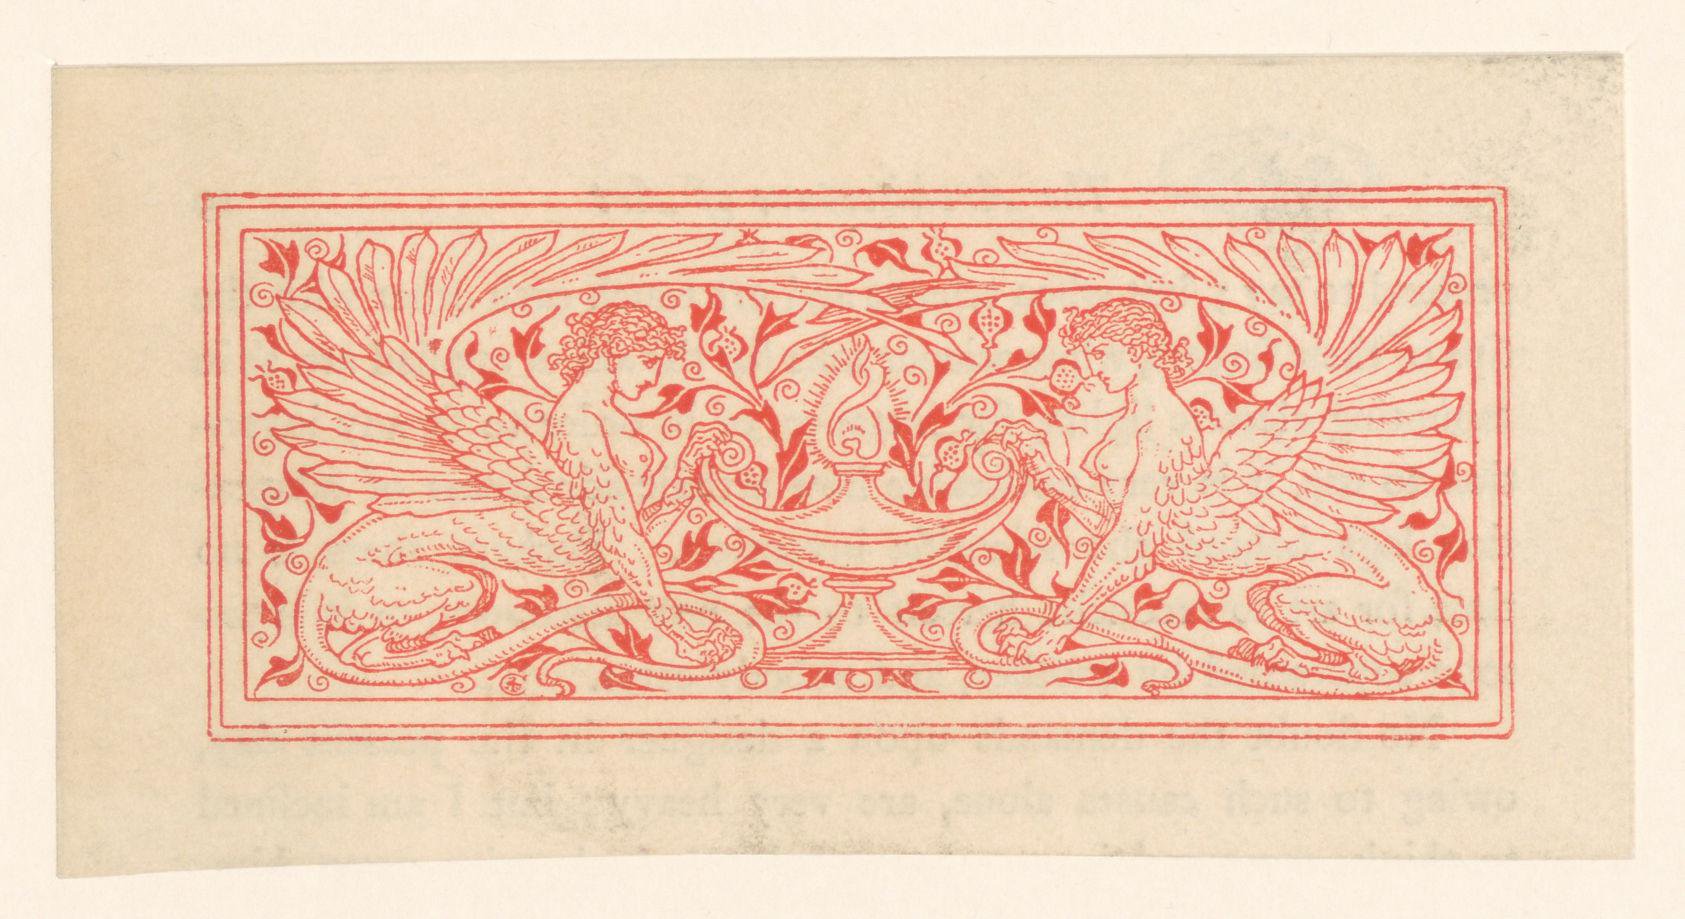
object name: book illustration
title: Twee sfinxen bij een lamp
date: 1892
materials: paper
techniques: letterpress printing, engraving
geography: london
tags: sphinx (lion/woman); 'sfinge' (ripa), lighting; lamps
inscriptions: collector's mark: Lugt 2228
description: Prent uit: Crane, Walter. The claims of decorative art. Londen: Lawrence & Bullen, 1892, p. 19-20.